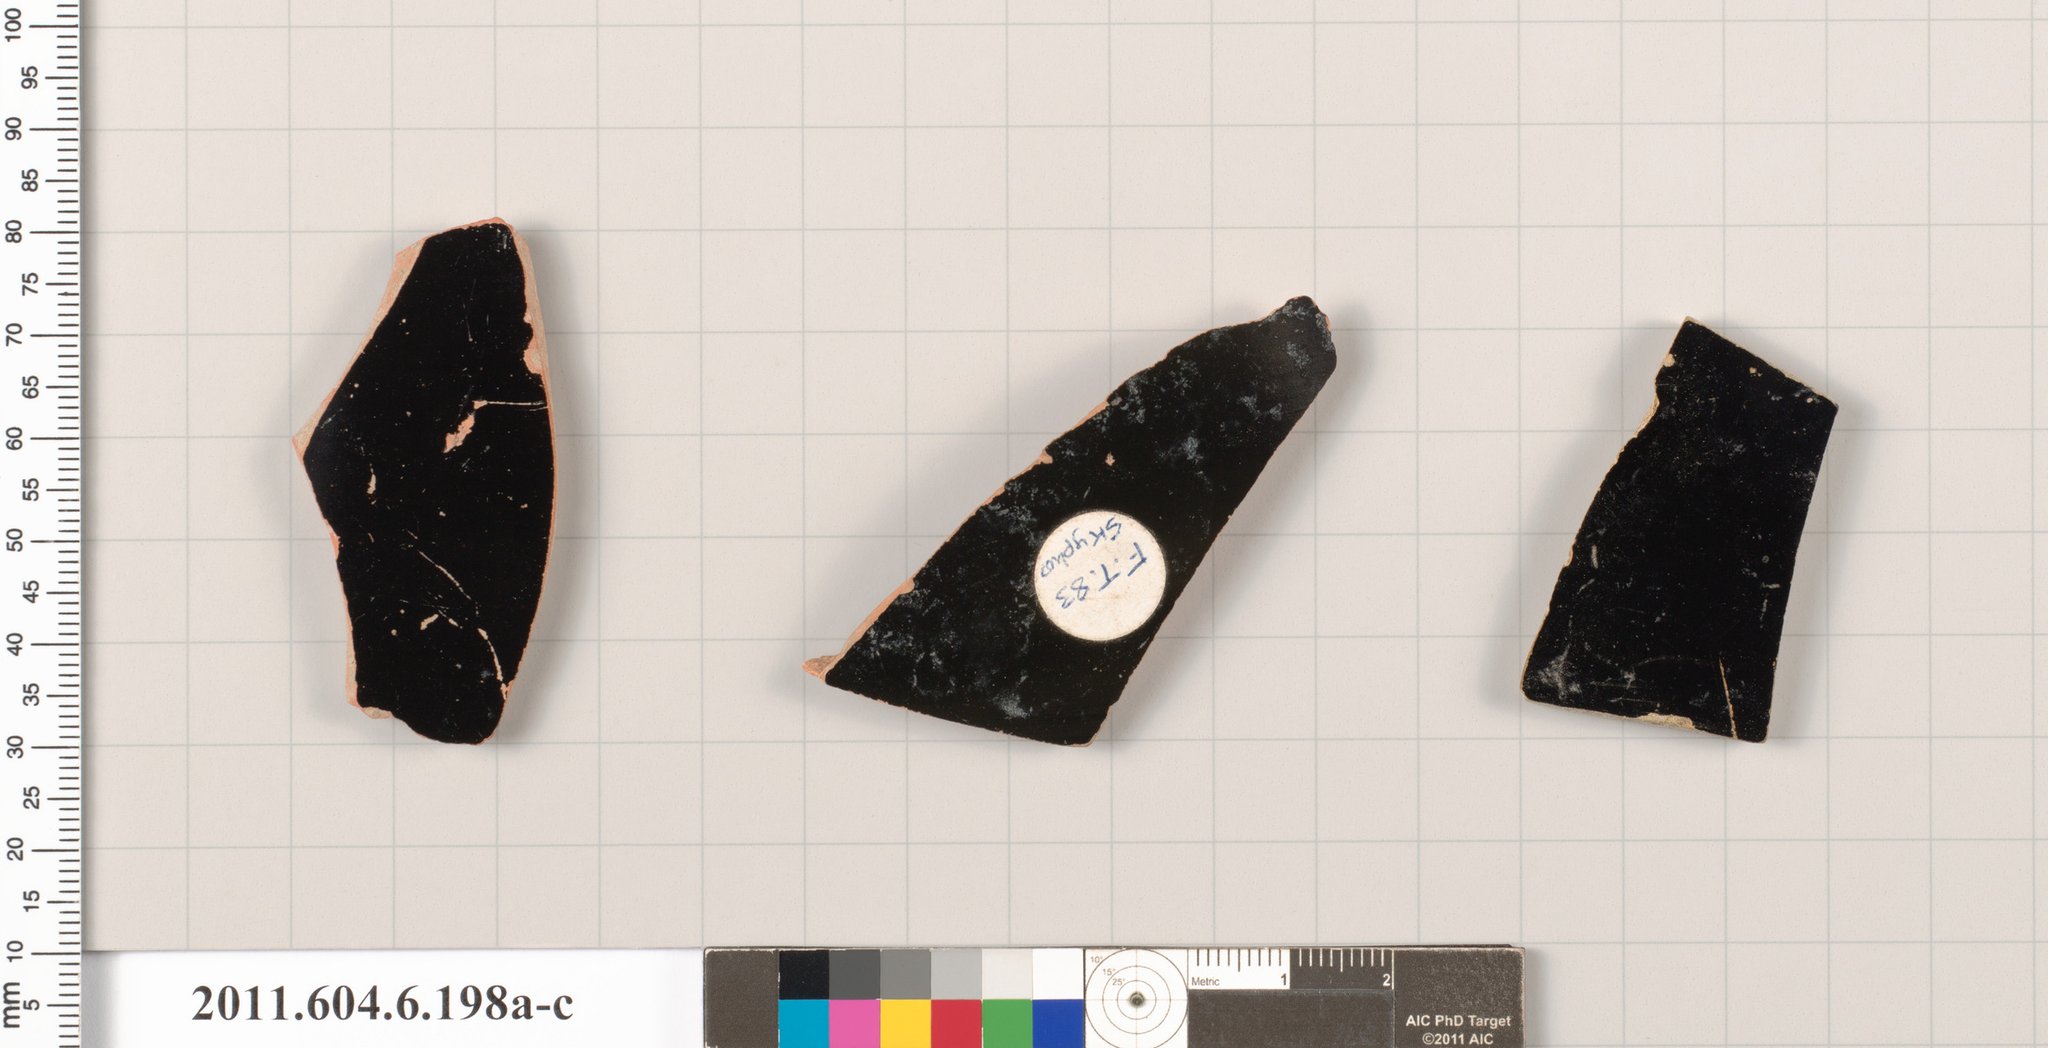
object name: skyphos fragment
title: Terracotta fragments of skyphoi (deep drinking cups)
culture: greek, attic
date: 500-401 BCE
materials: terracotta